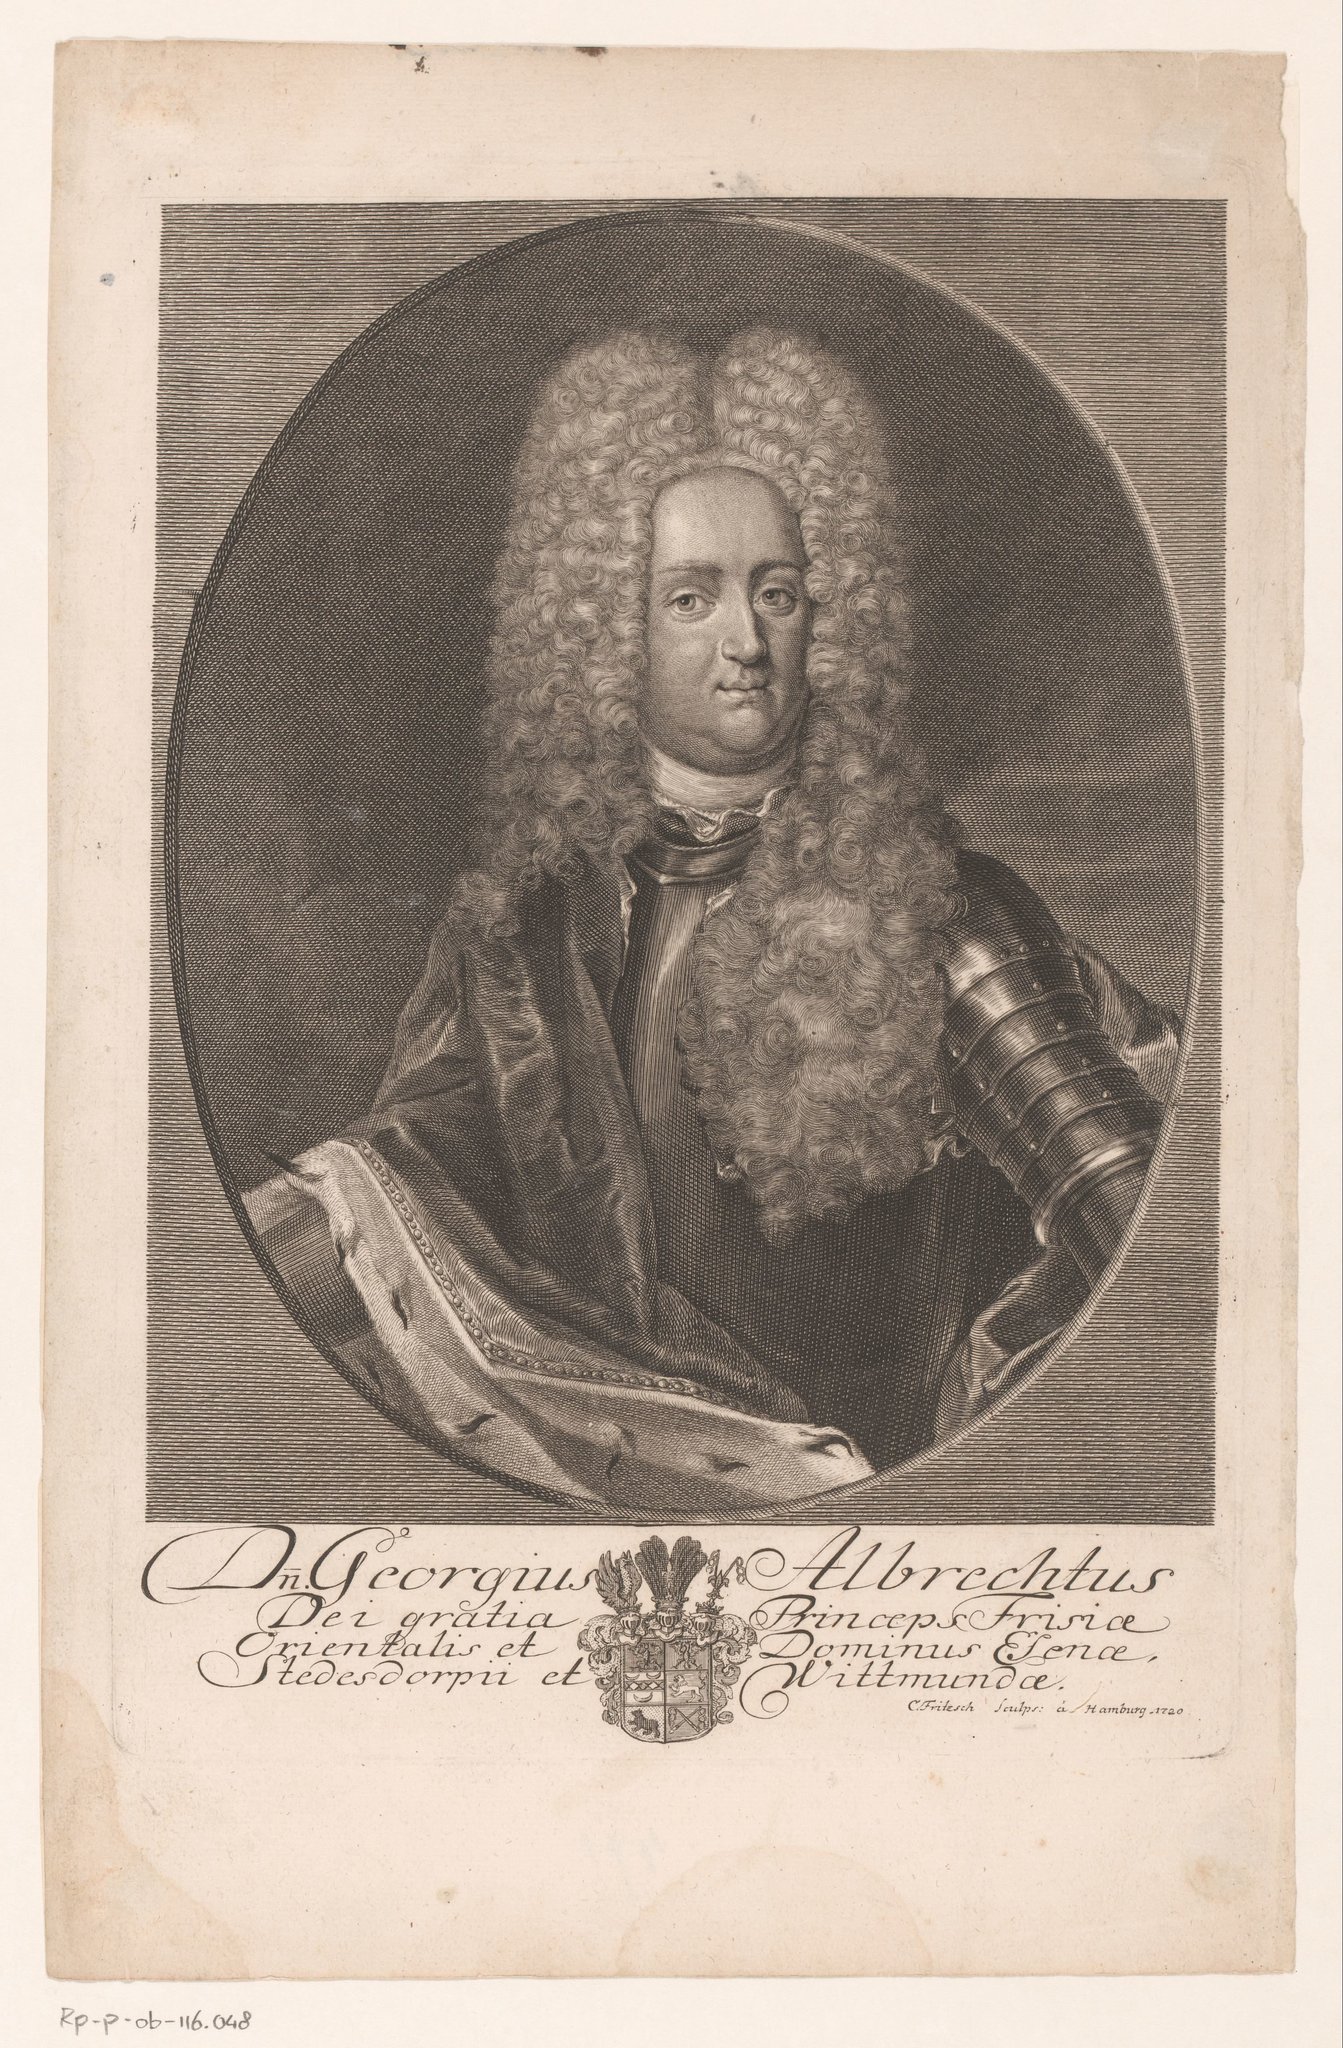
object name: print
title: Portret van Georg Albrecht van Oost-Friesland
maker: christian fritzsch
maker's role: print maker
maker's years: 1695-1769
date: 1720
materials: paper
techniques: engraving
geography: hamburg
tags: armour, historical persons, armorial bearing, heraldry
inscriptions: collector's mark: Lugt 2228